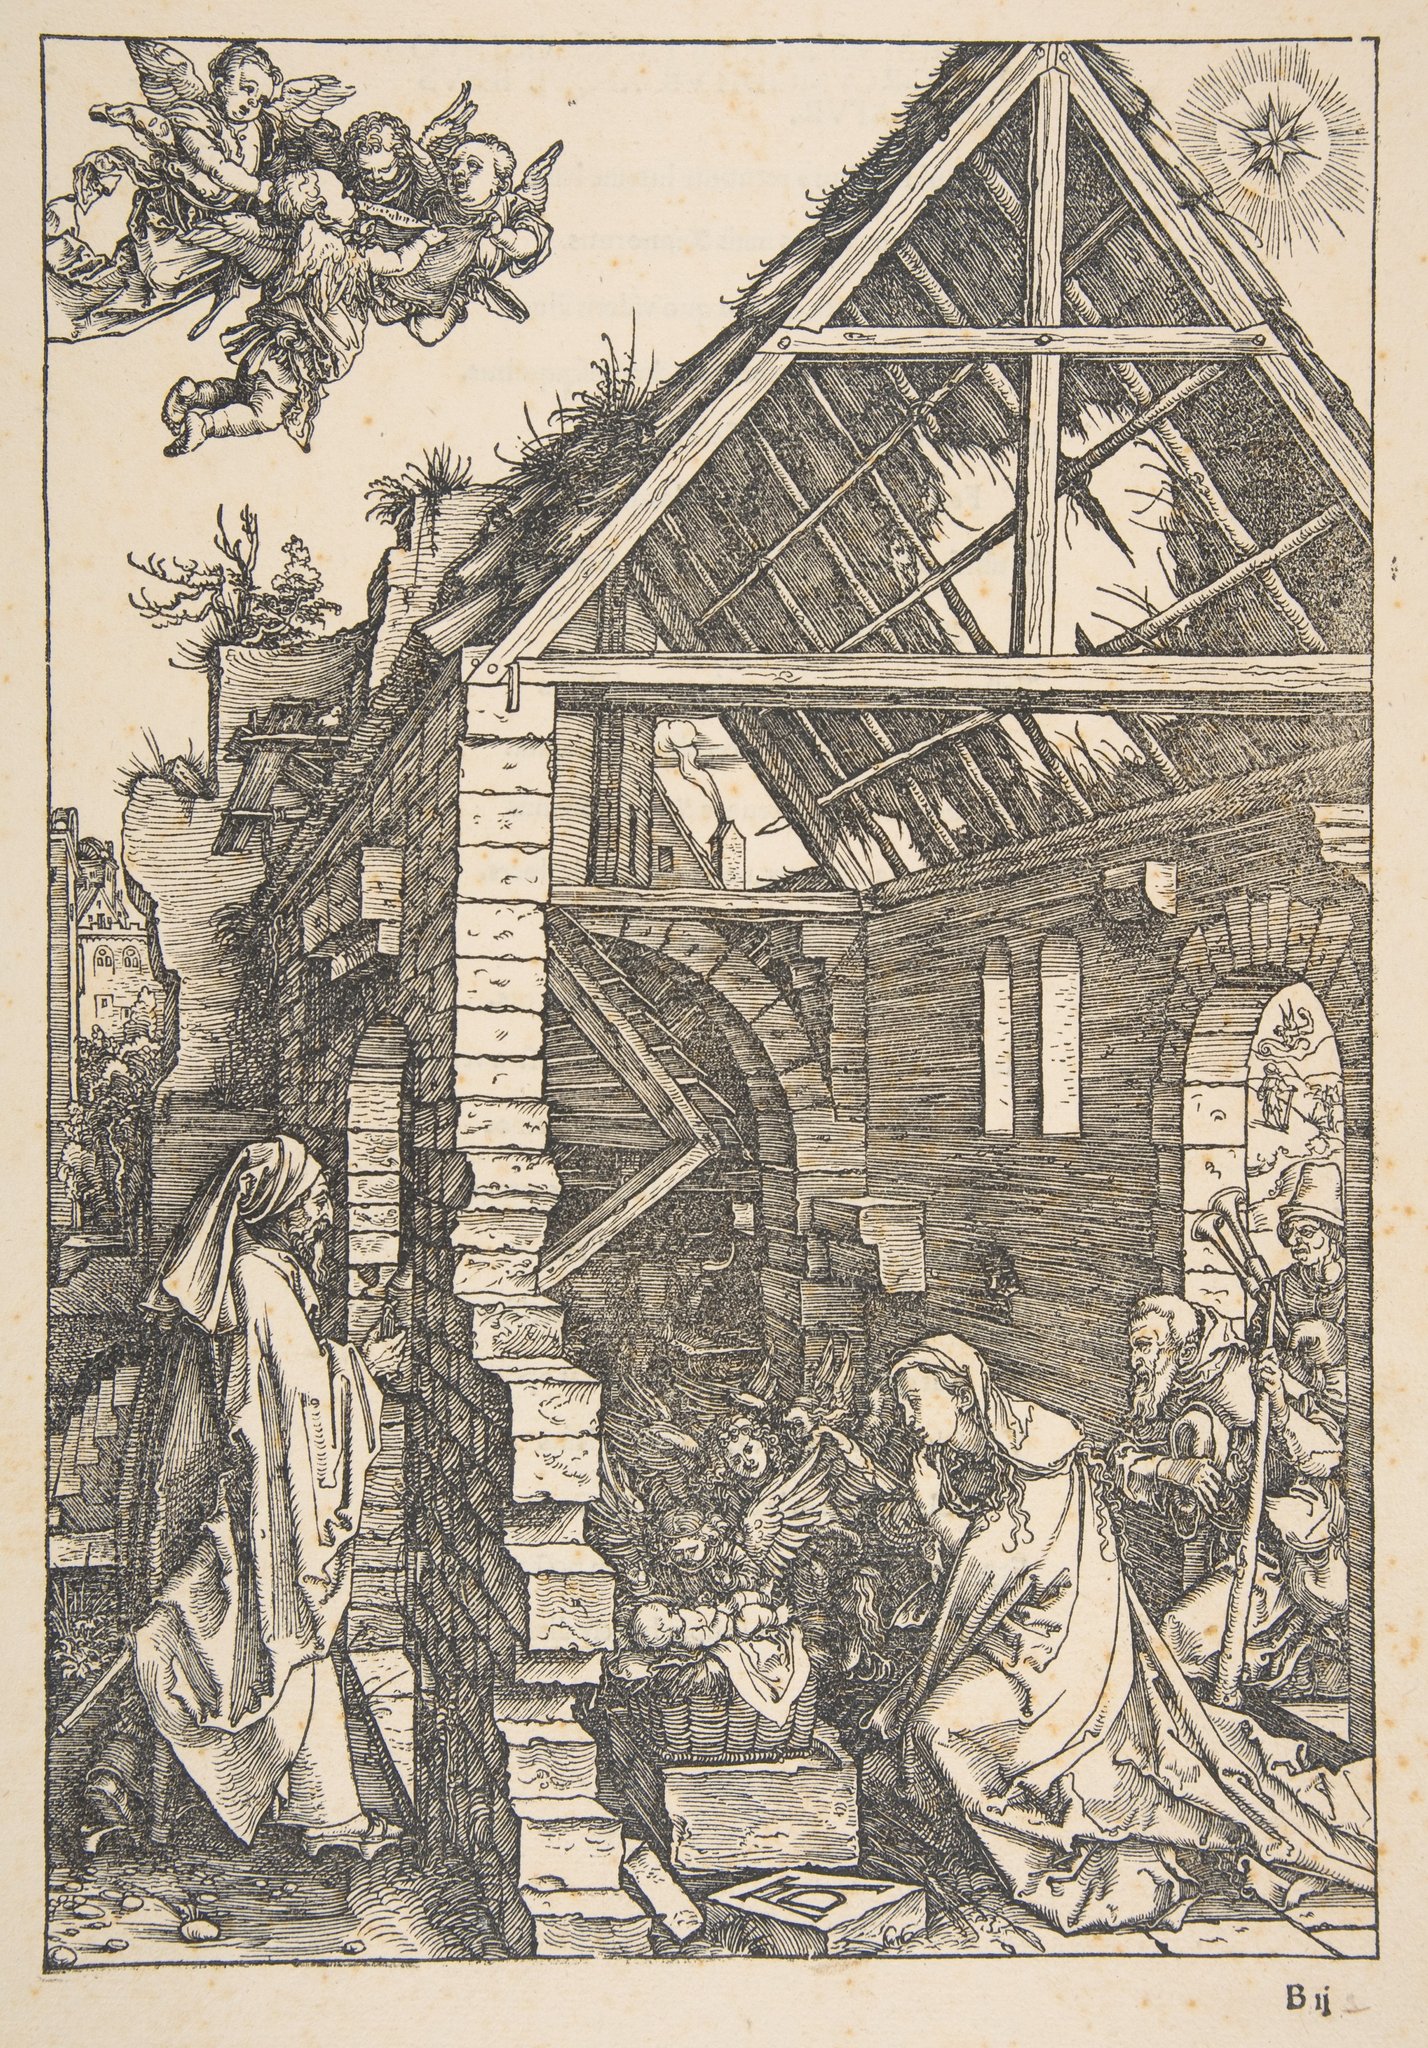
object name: print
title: The Nativity, from "The Life of the Virgin"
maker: albrecht dürer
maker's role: artist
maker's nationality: german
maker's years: 1471-1528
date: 1502-1503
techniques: woodcut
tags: ruins,angels,virgin mary,jesus,nativity